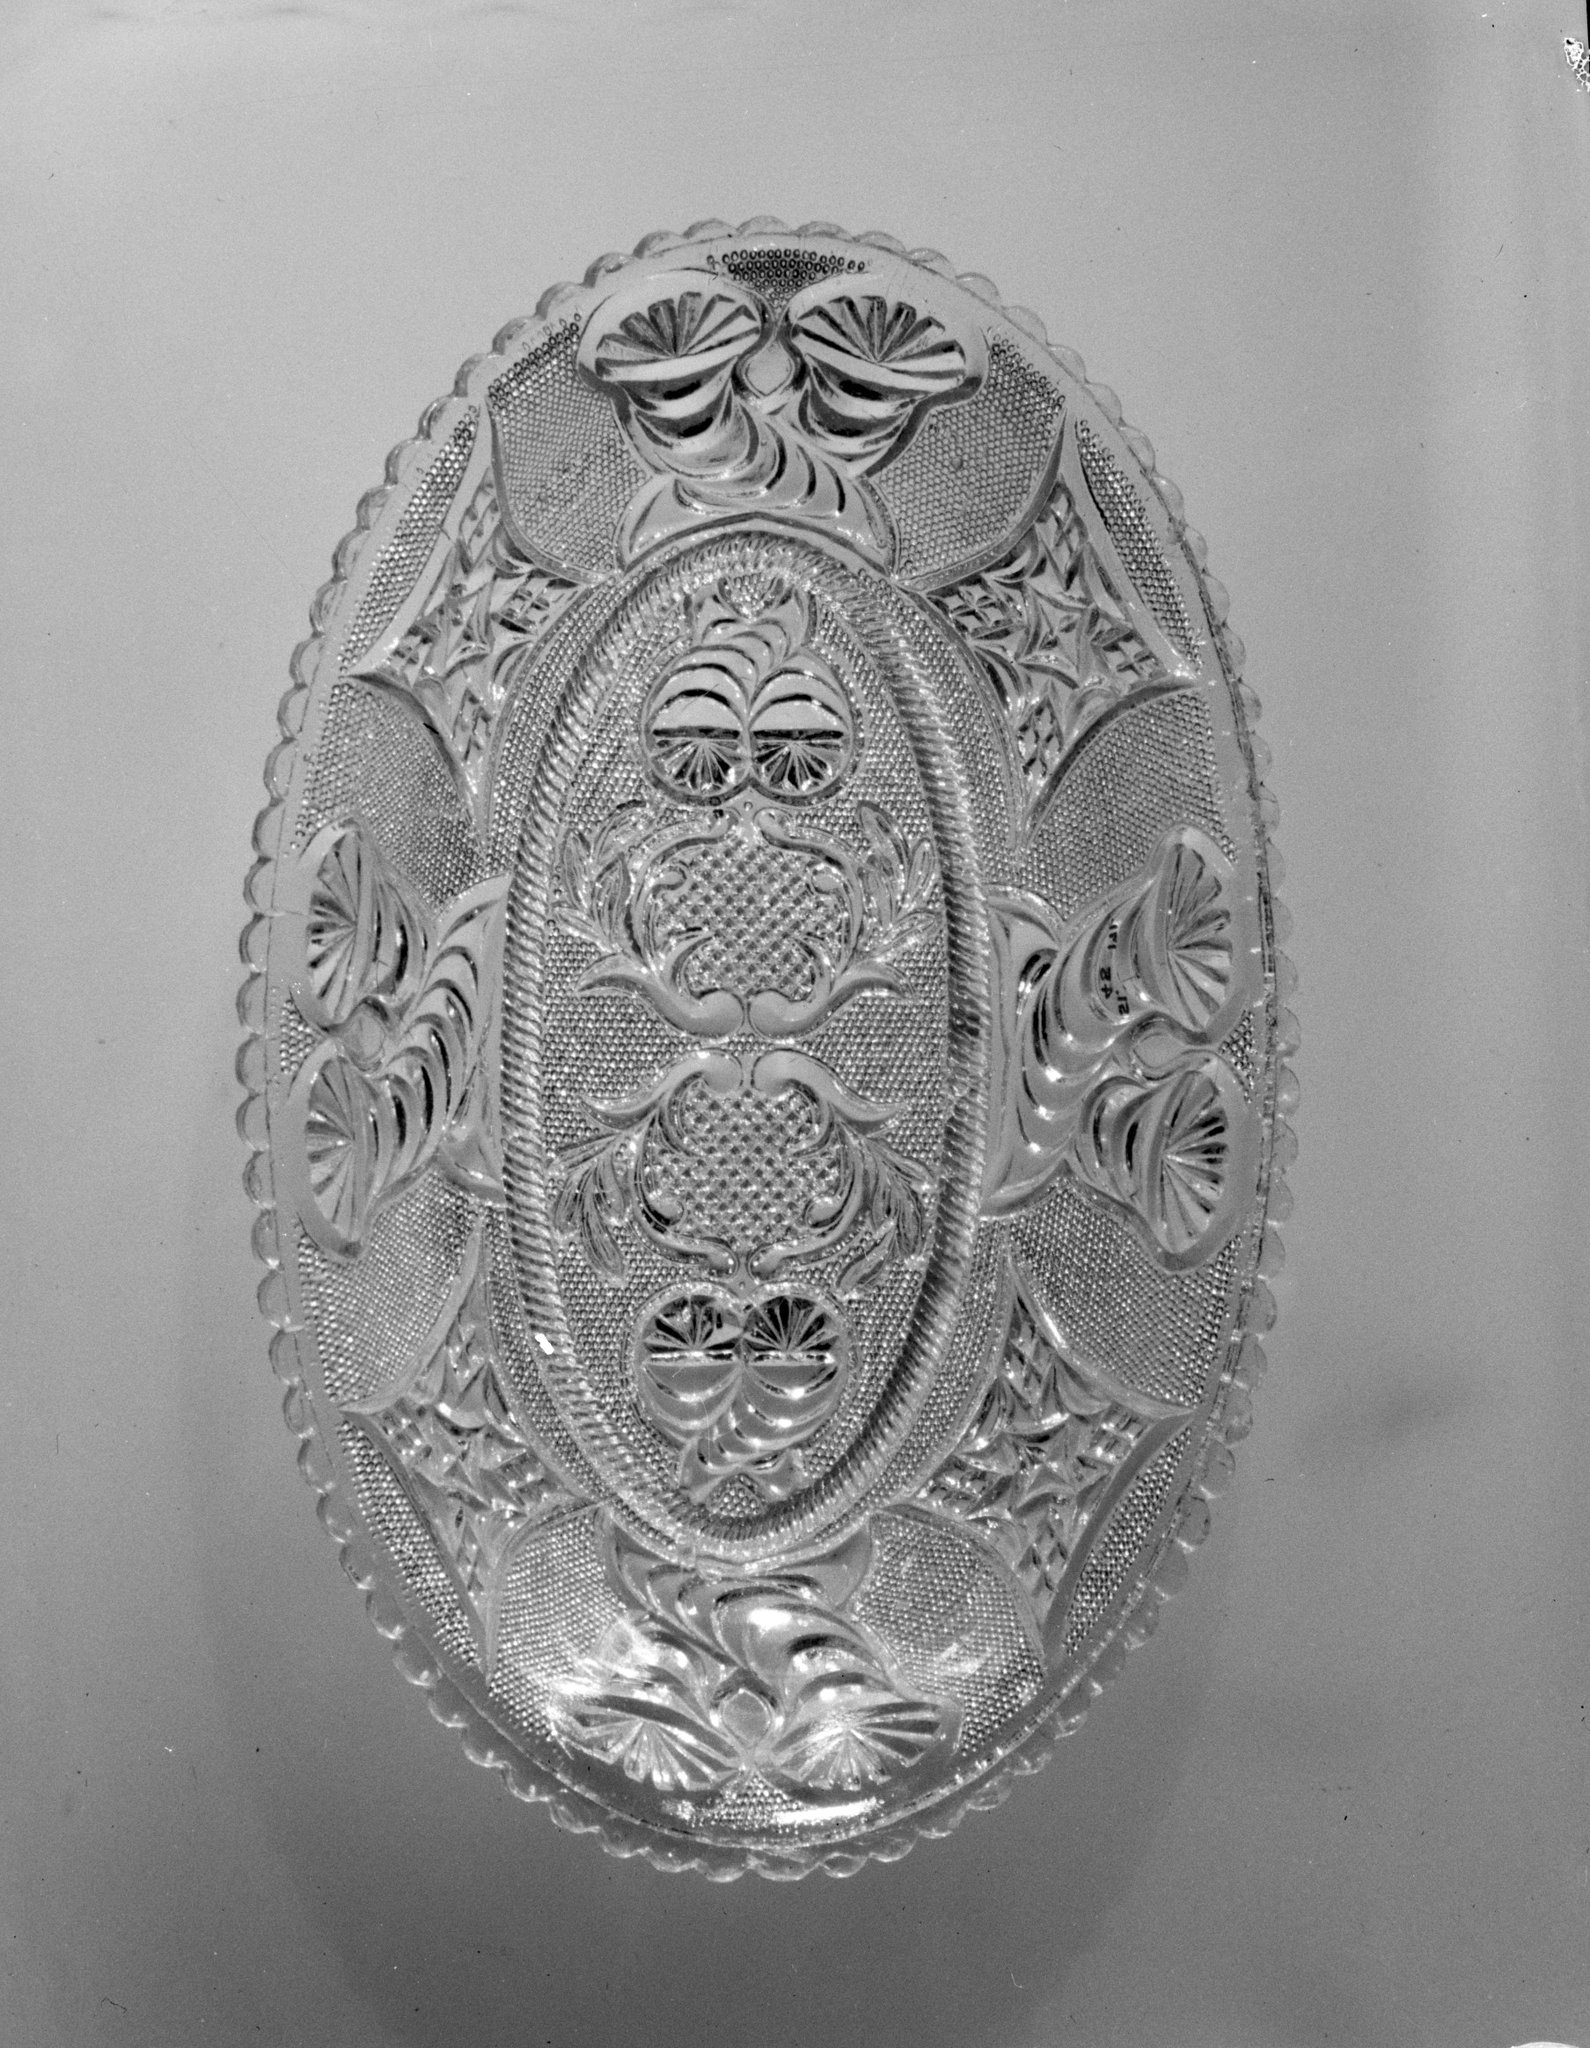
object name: dish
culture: american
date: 1830-1845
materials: glass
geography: united states